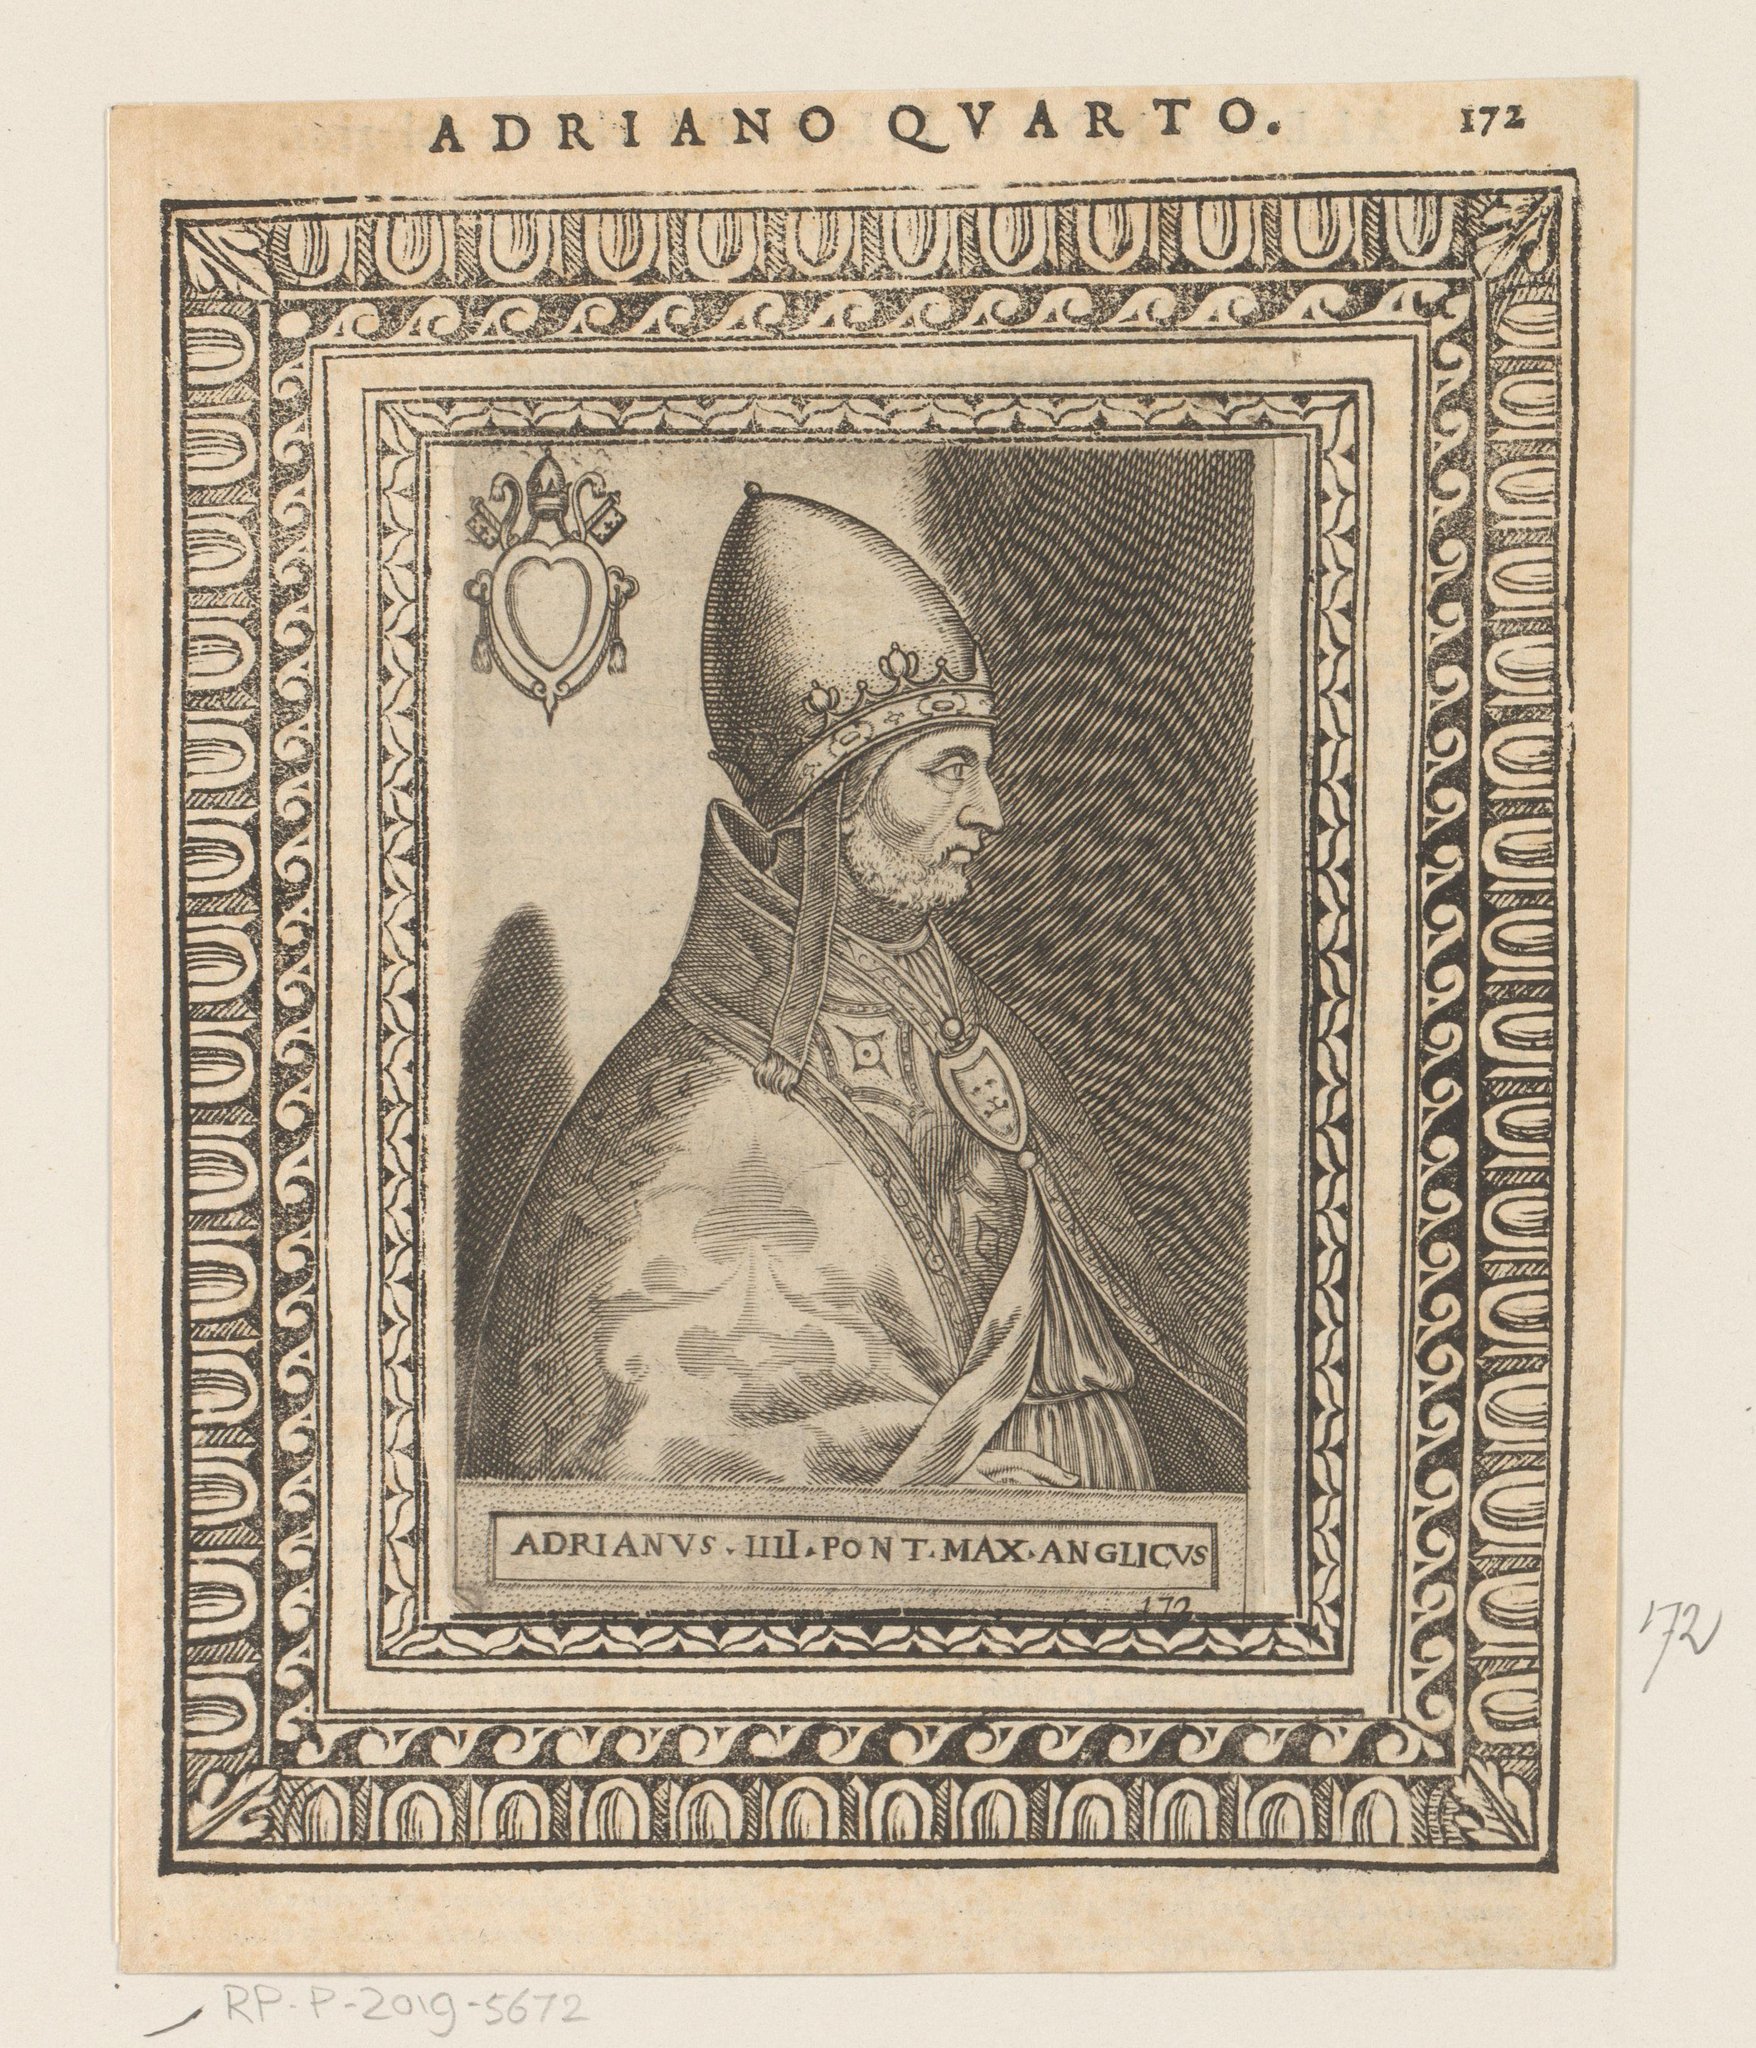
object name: print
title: Portret van paus Adrianus IV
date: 1587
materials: paper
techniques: engraving, letterpress printing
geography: rome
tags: historical persons, pope, armorial bearing, heraldry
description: Prent uit: Ciccarelli, Antonio. Le vite de Pontefici di Antonio Ciccarelli (...). Rome: Domenico Basa, 1587. Prent voor het eerst verschenen in: Cavalieri, Giovanni Battista de'. Pontificum romanorum effigies (...). Rome: Domenico Basa en Francesco Zanetti, 1580. Prent ook gebruikt in latere publicaties.